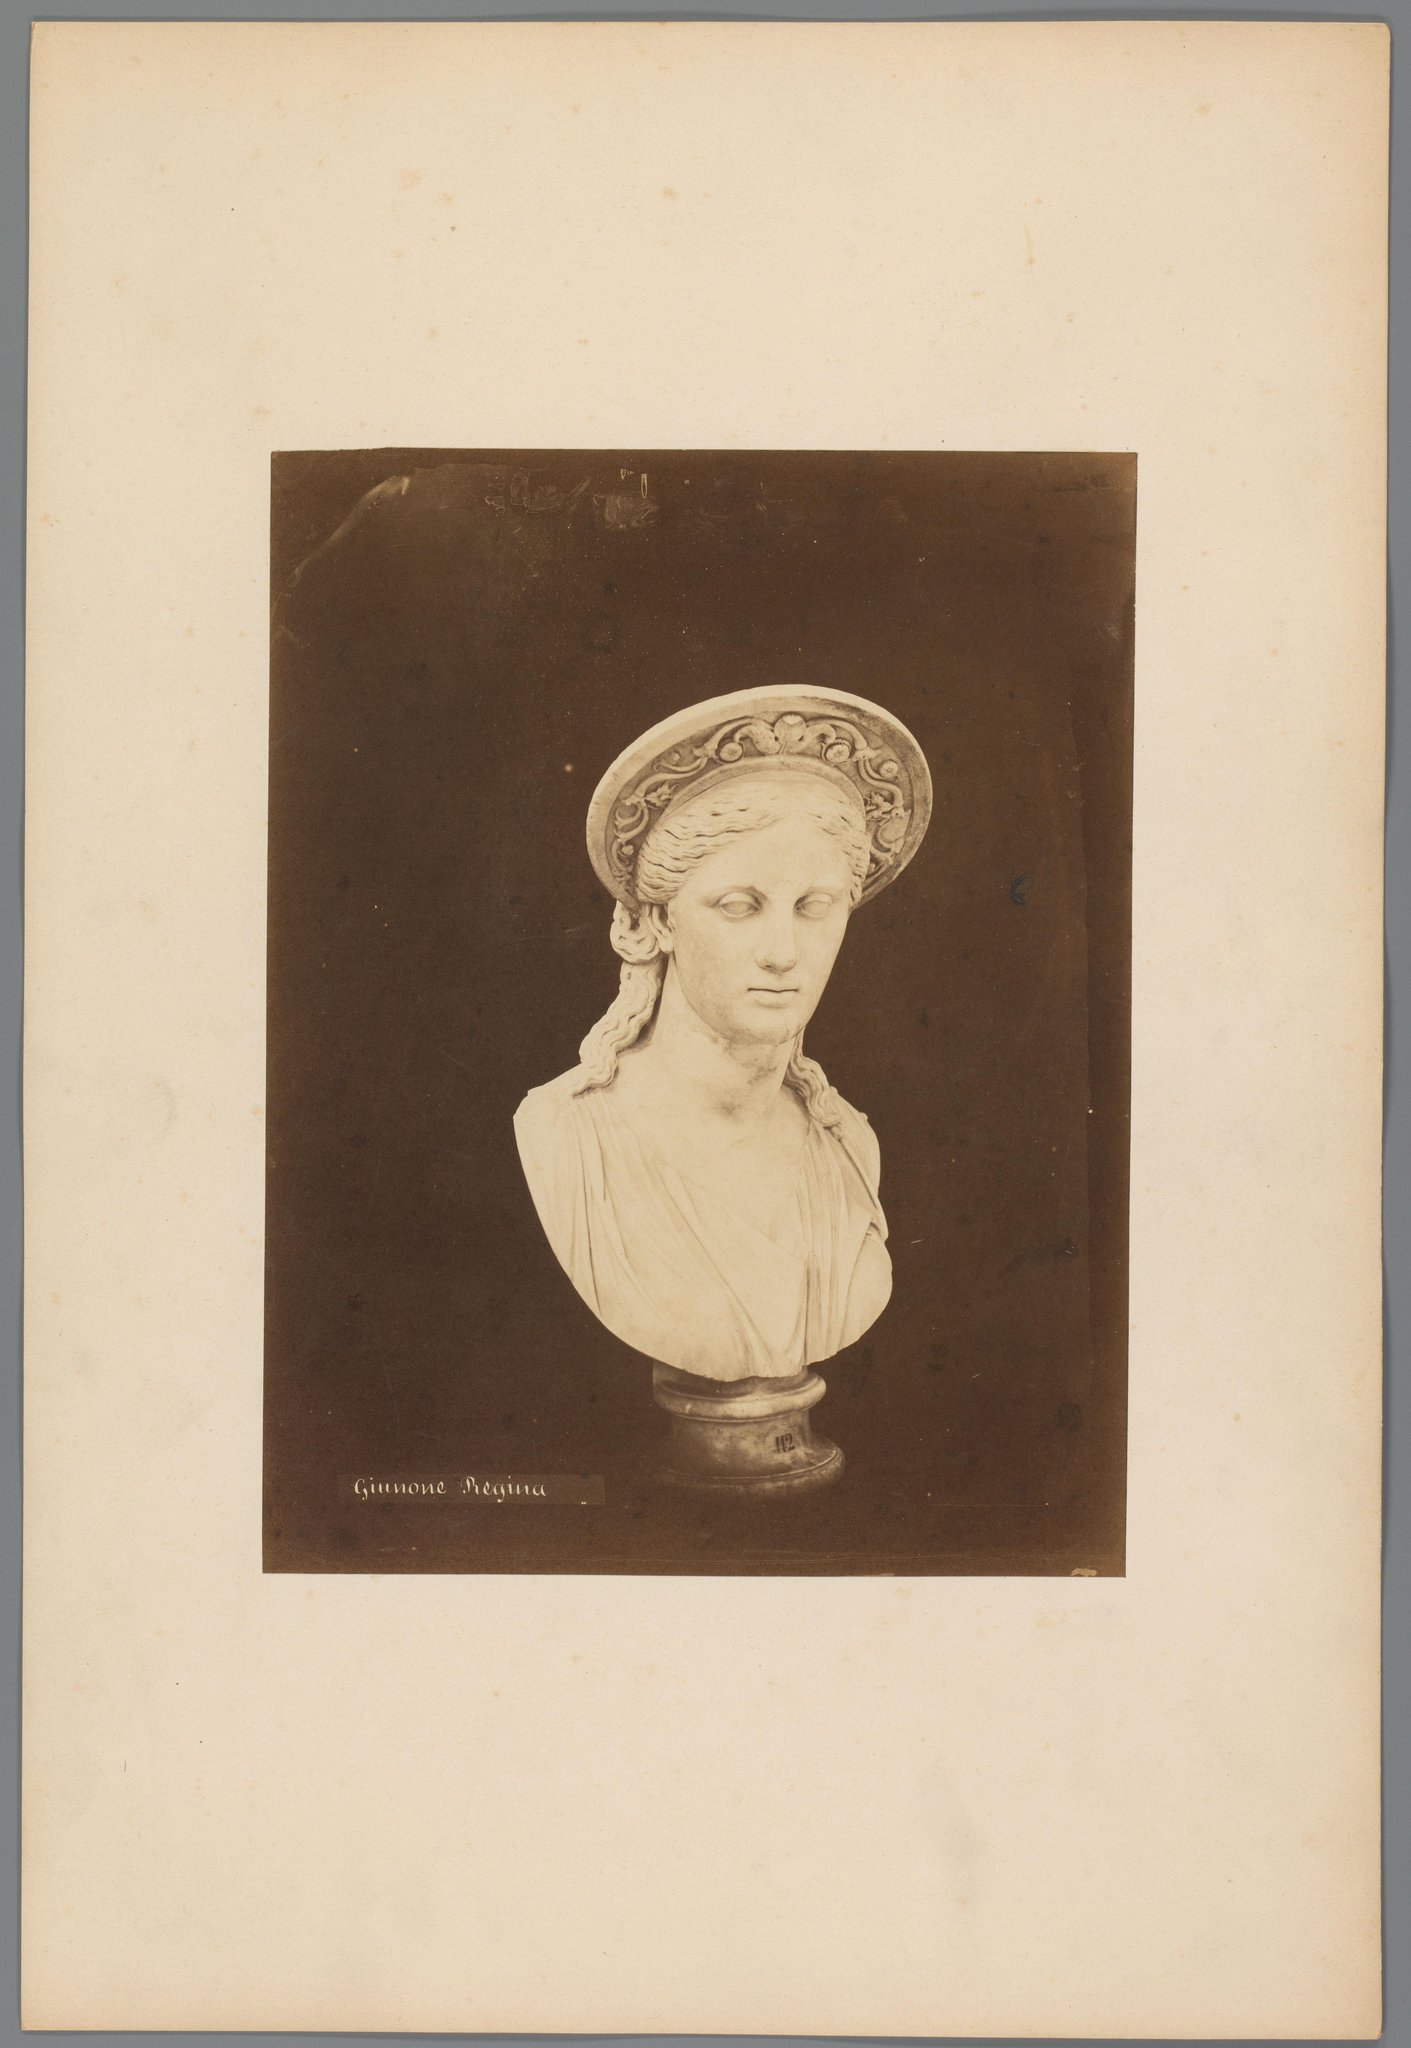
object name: photograph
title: Giunone Regina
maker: Anonymous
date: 1851-1900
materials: cardboard, paper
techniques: albumen print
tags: head (human), (story of) juno (hera), piece of sculpture, reproduction of a piece of sculpture